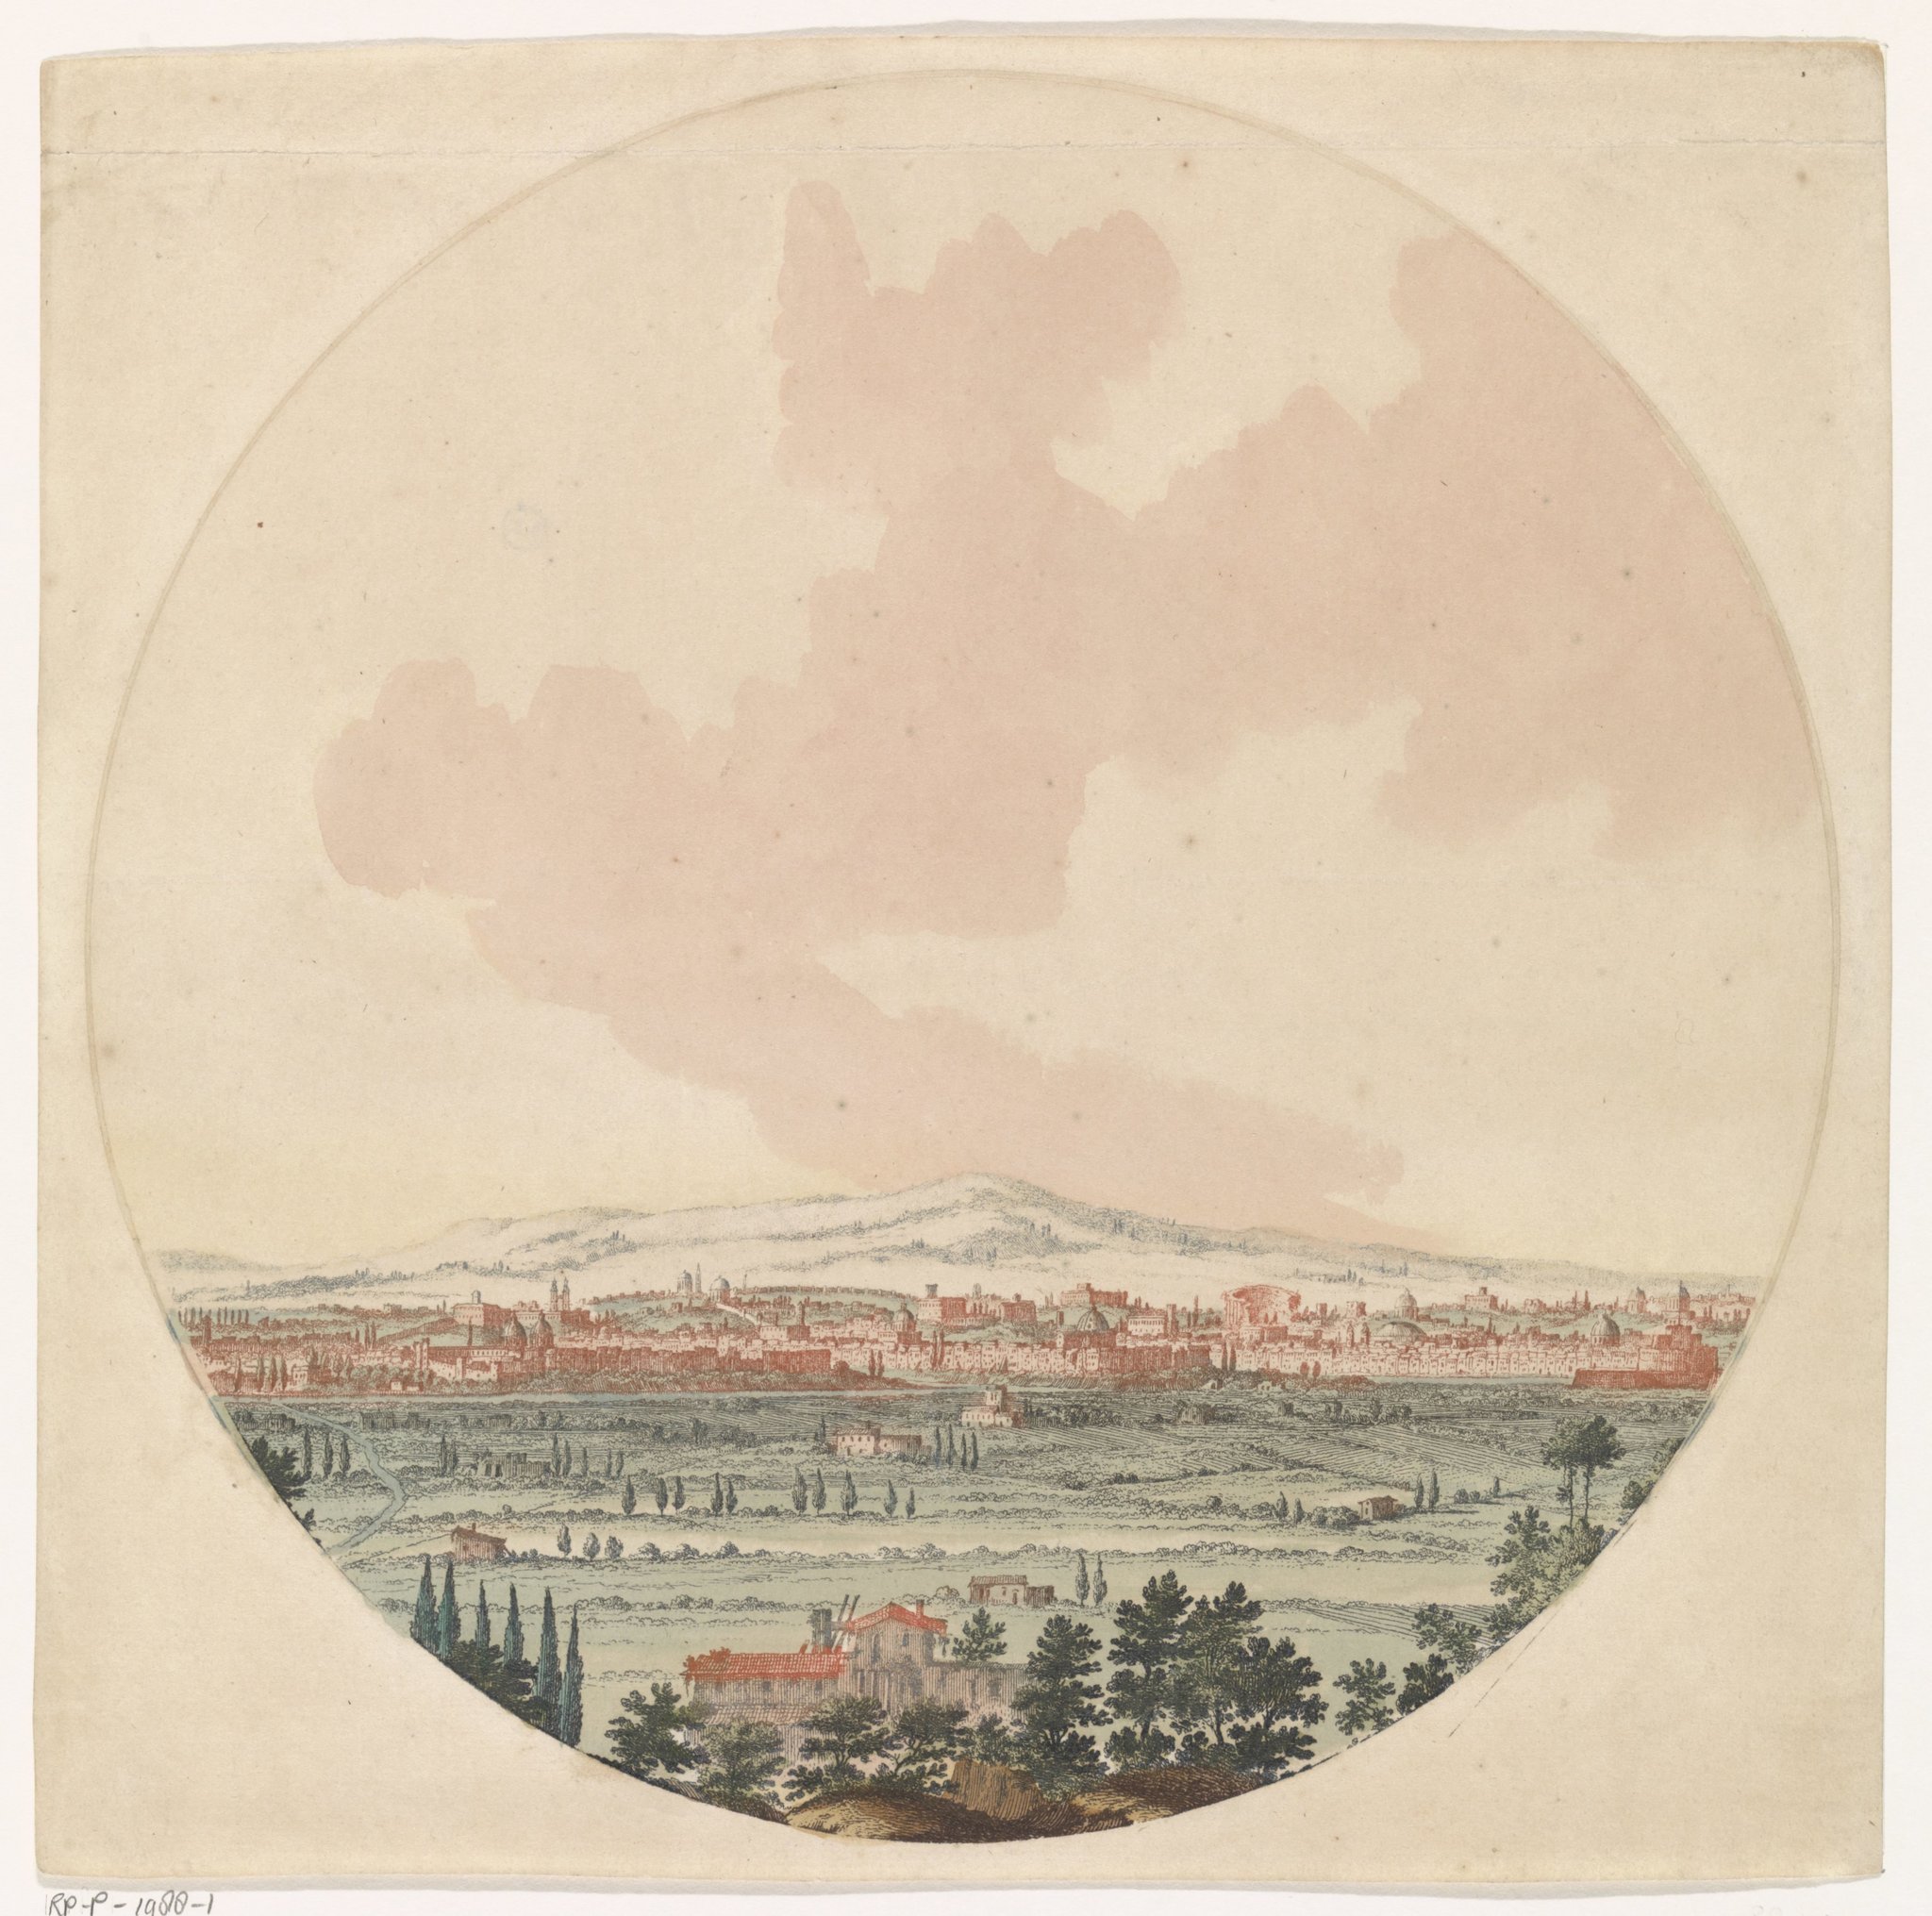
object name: print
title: Gezicht op de stad Rome en het omliggende landschap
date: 1688-1698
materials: paper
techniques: etching, hand coloring, lithography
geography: netherlands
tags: city-view in general; 'veduta', rome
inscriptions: collector's mark: Lugt 1138c, collector's mark: Lugt 2228, collector's mark: Lugt 2760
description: Gezicht op de stad Rome. Op de voorgrond het omliggende landschap met cipressen en buitenhuizen.